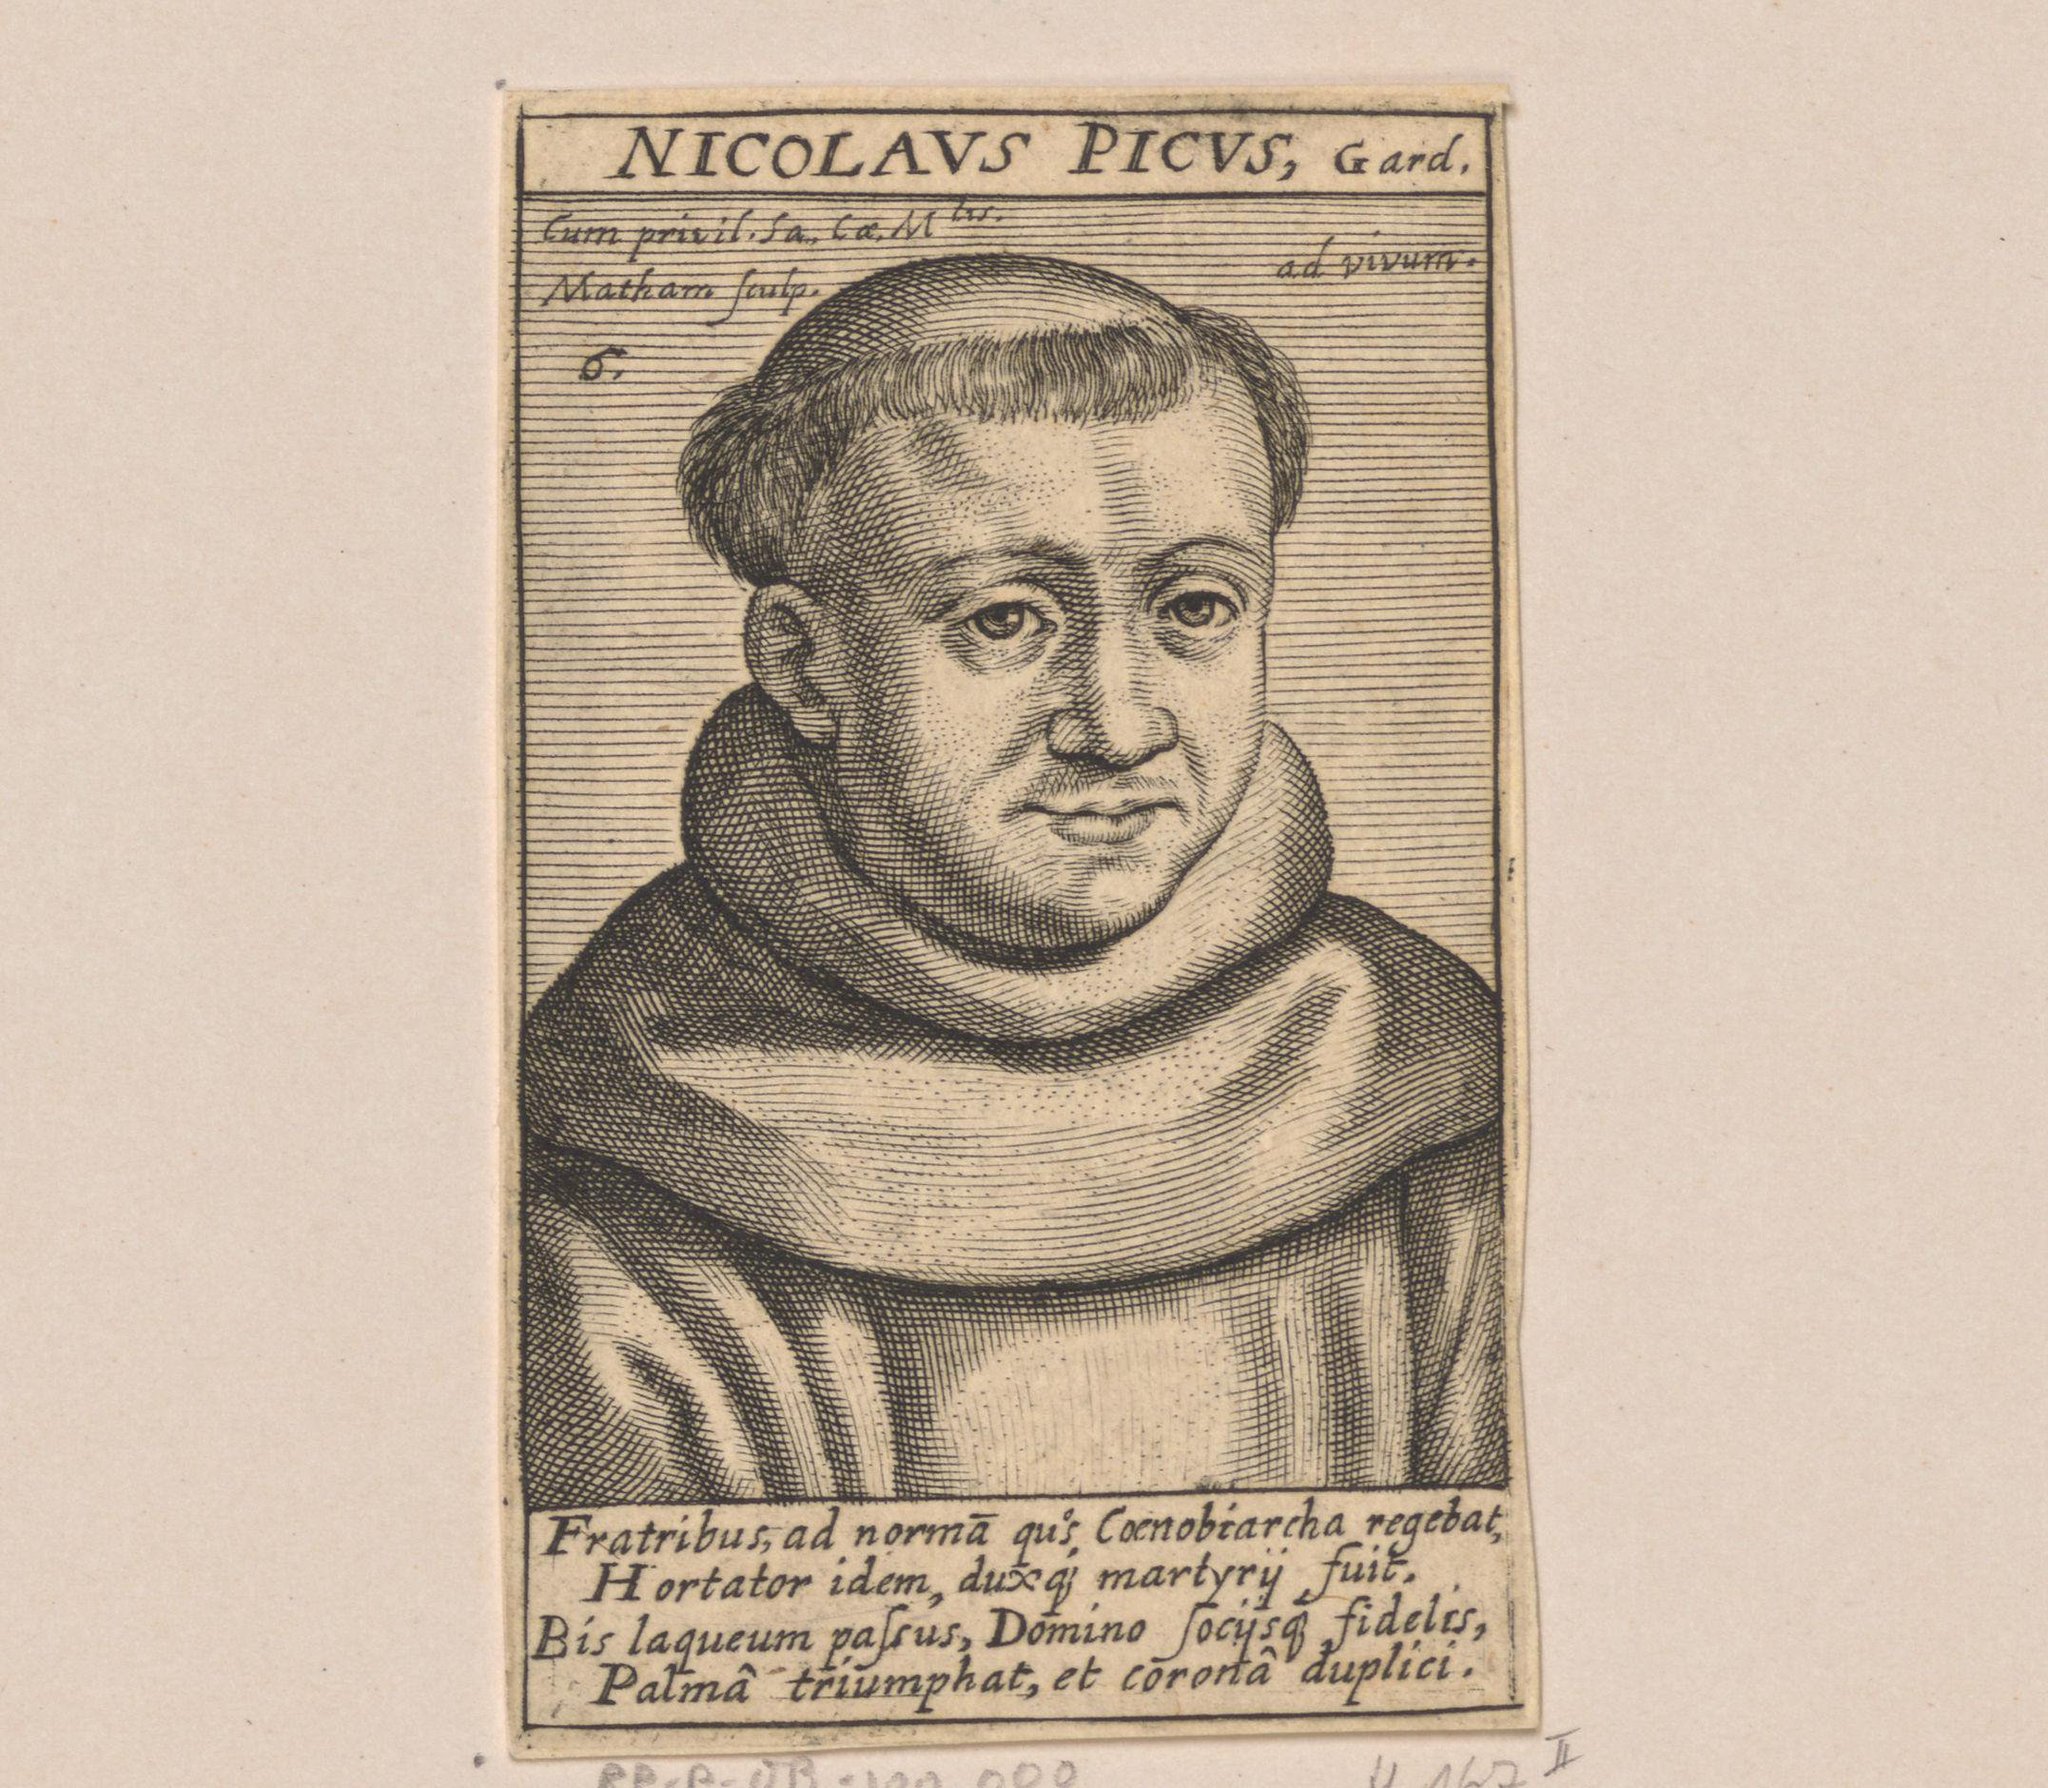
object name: print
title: Portret van Nicolaus Picus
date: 1617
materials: paper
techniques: engraving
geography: haarlem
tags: brielle, priest, historical persons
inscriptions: collector's mark: Lugt 964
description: Portret van de heilige Nicolaus Picus, een van de negentien katholieke martelaren van Gorinchem.